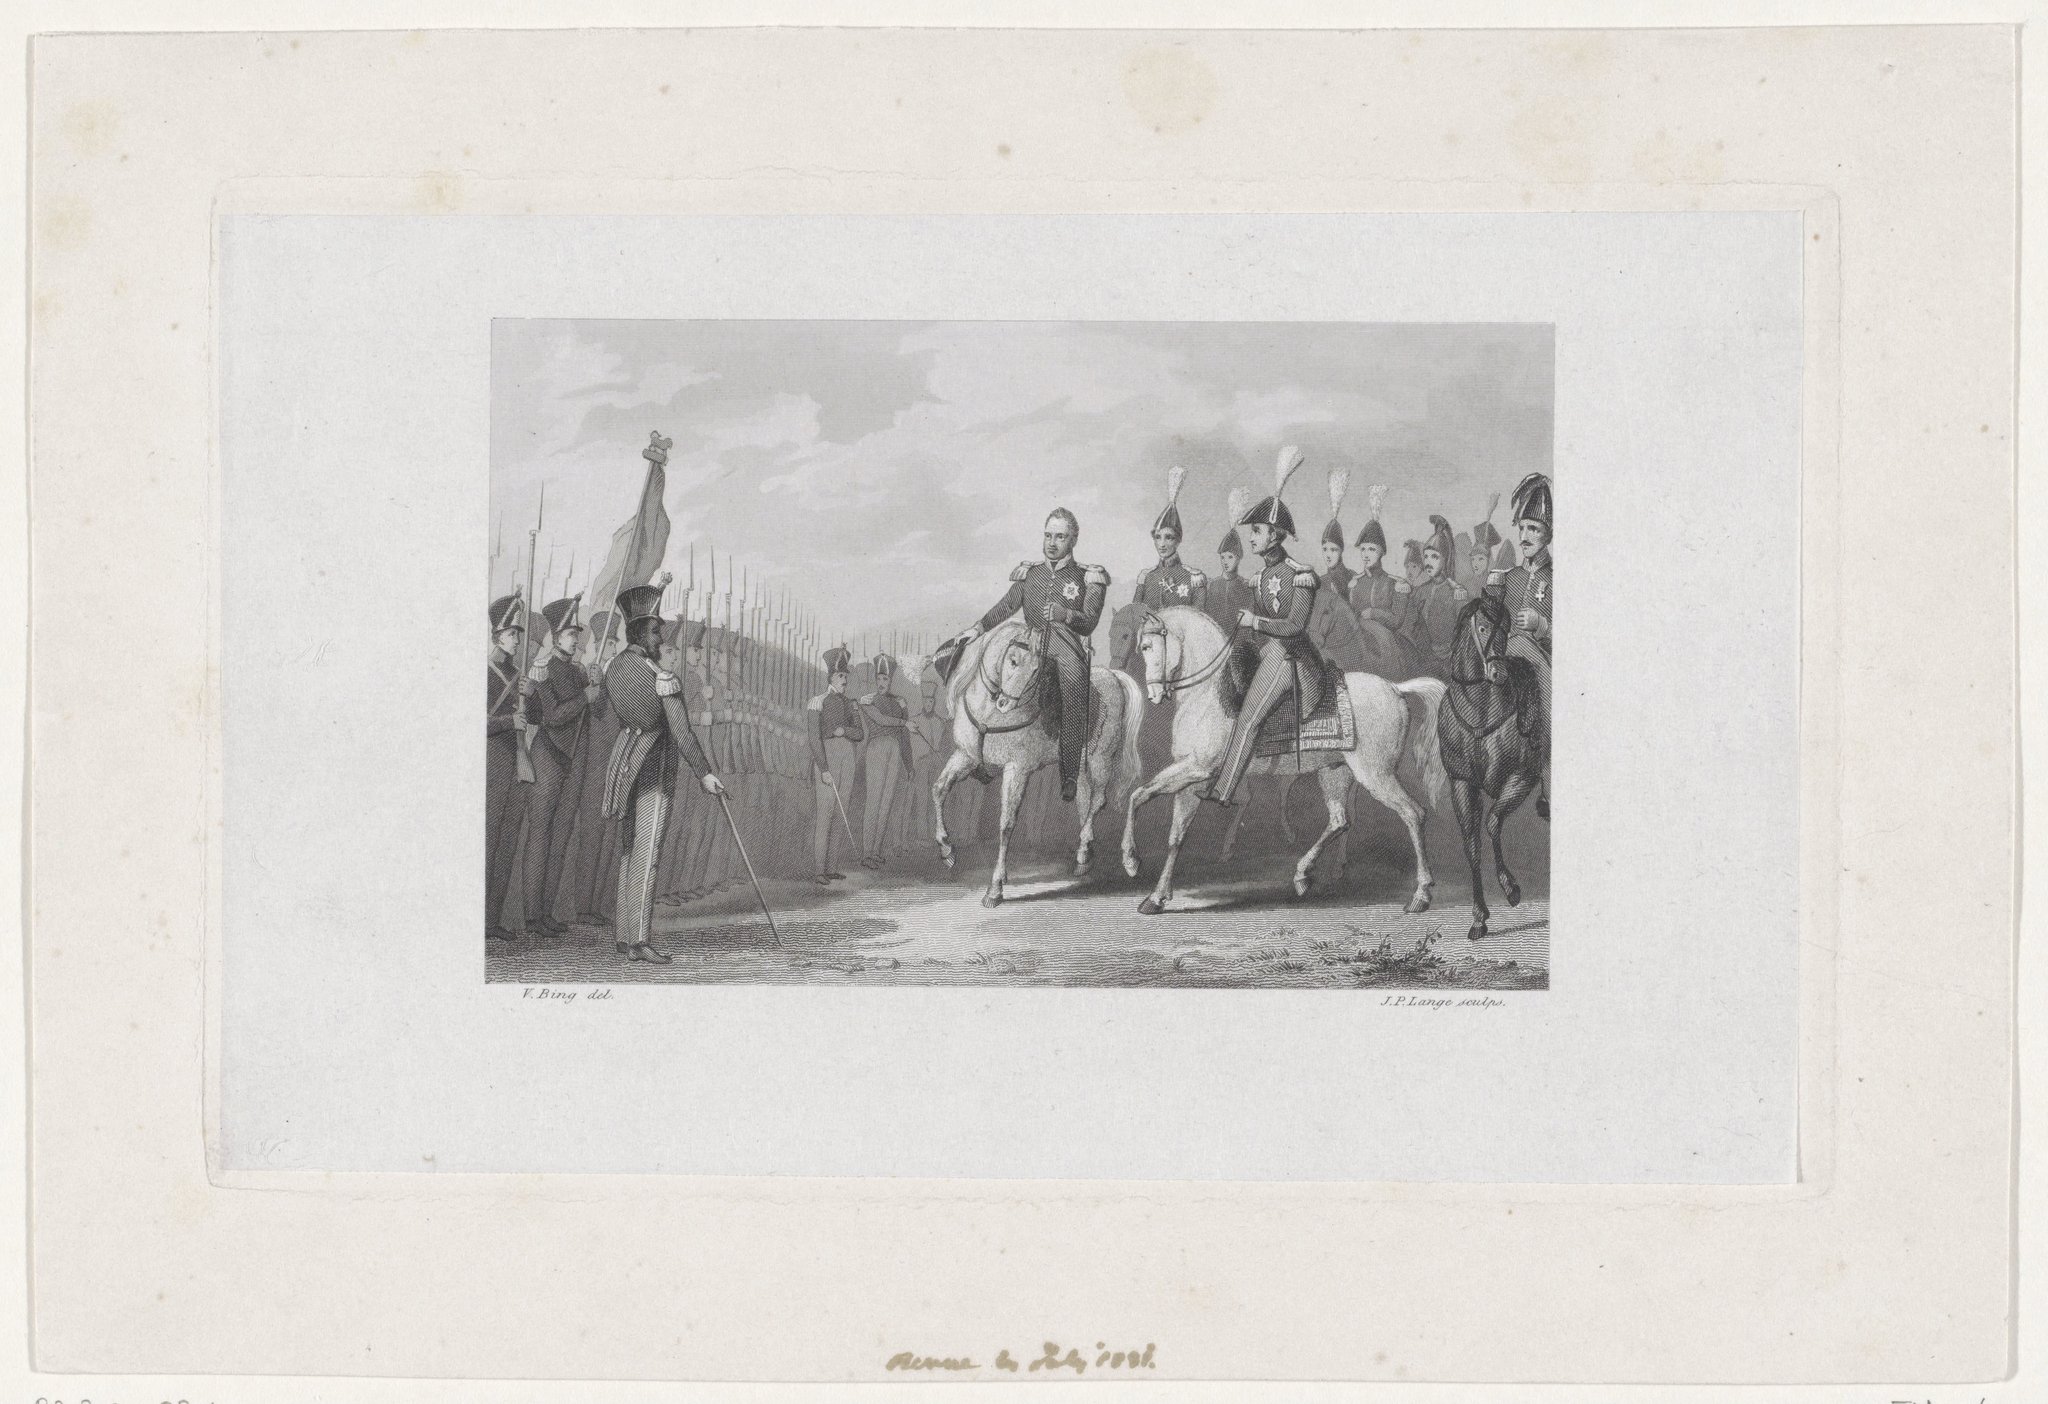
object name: history print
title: Koning Willem I bezoekt het legerkamp bij Rijen, 1831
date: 1843-1845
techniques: printmaking, engraving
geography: netherlands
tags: berlin, william i of the netherlands, review, inspection (of company, unit, troop)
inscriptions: collector's mark: Lugt 2228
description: Gebruikt als illustratie in: Het leven en de regering van Z. M. Willem I, koning der Nederlanden, groot-Hertog van Luxemburg enz., enz., enz. / door G. Engelberts Gerrits. Amsterdam : Van Kampen, 1845.